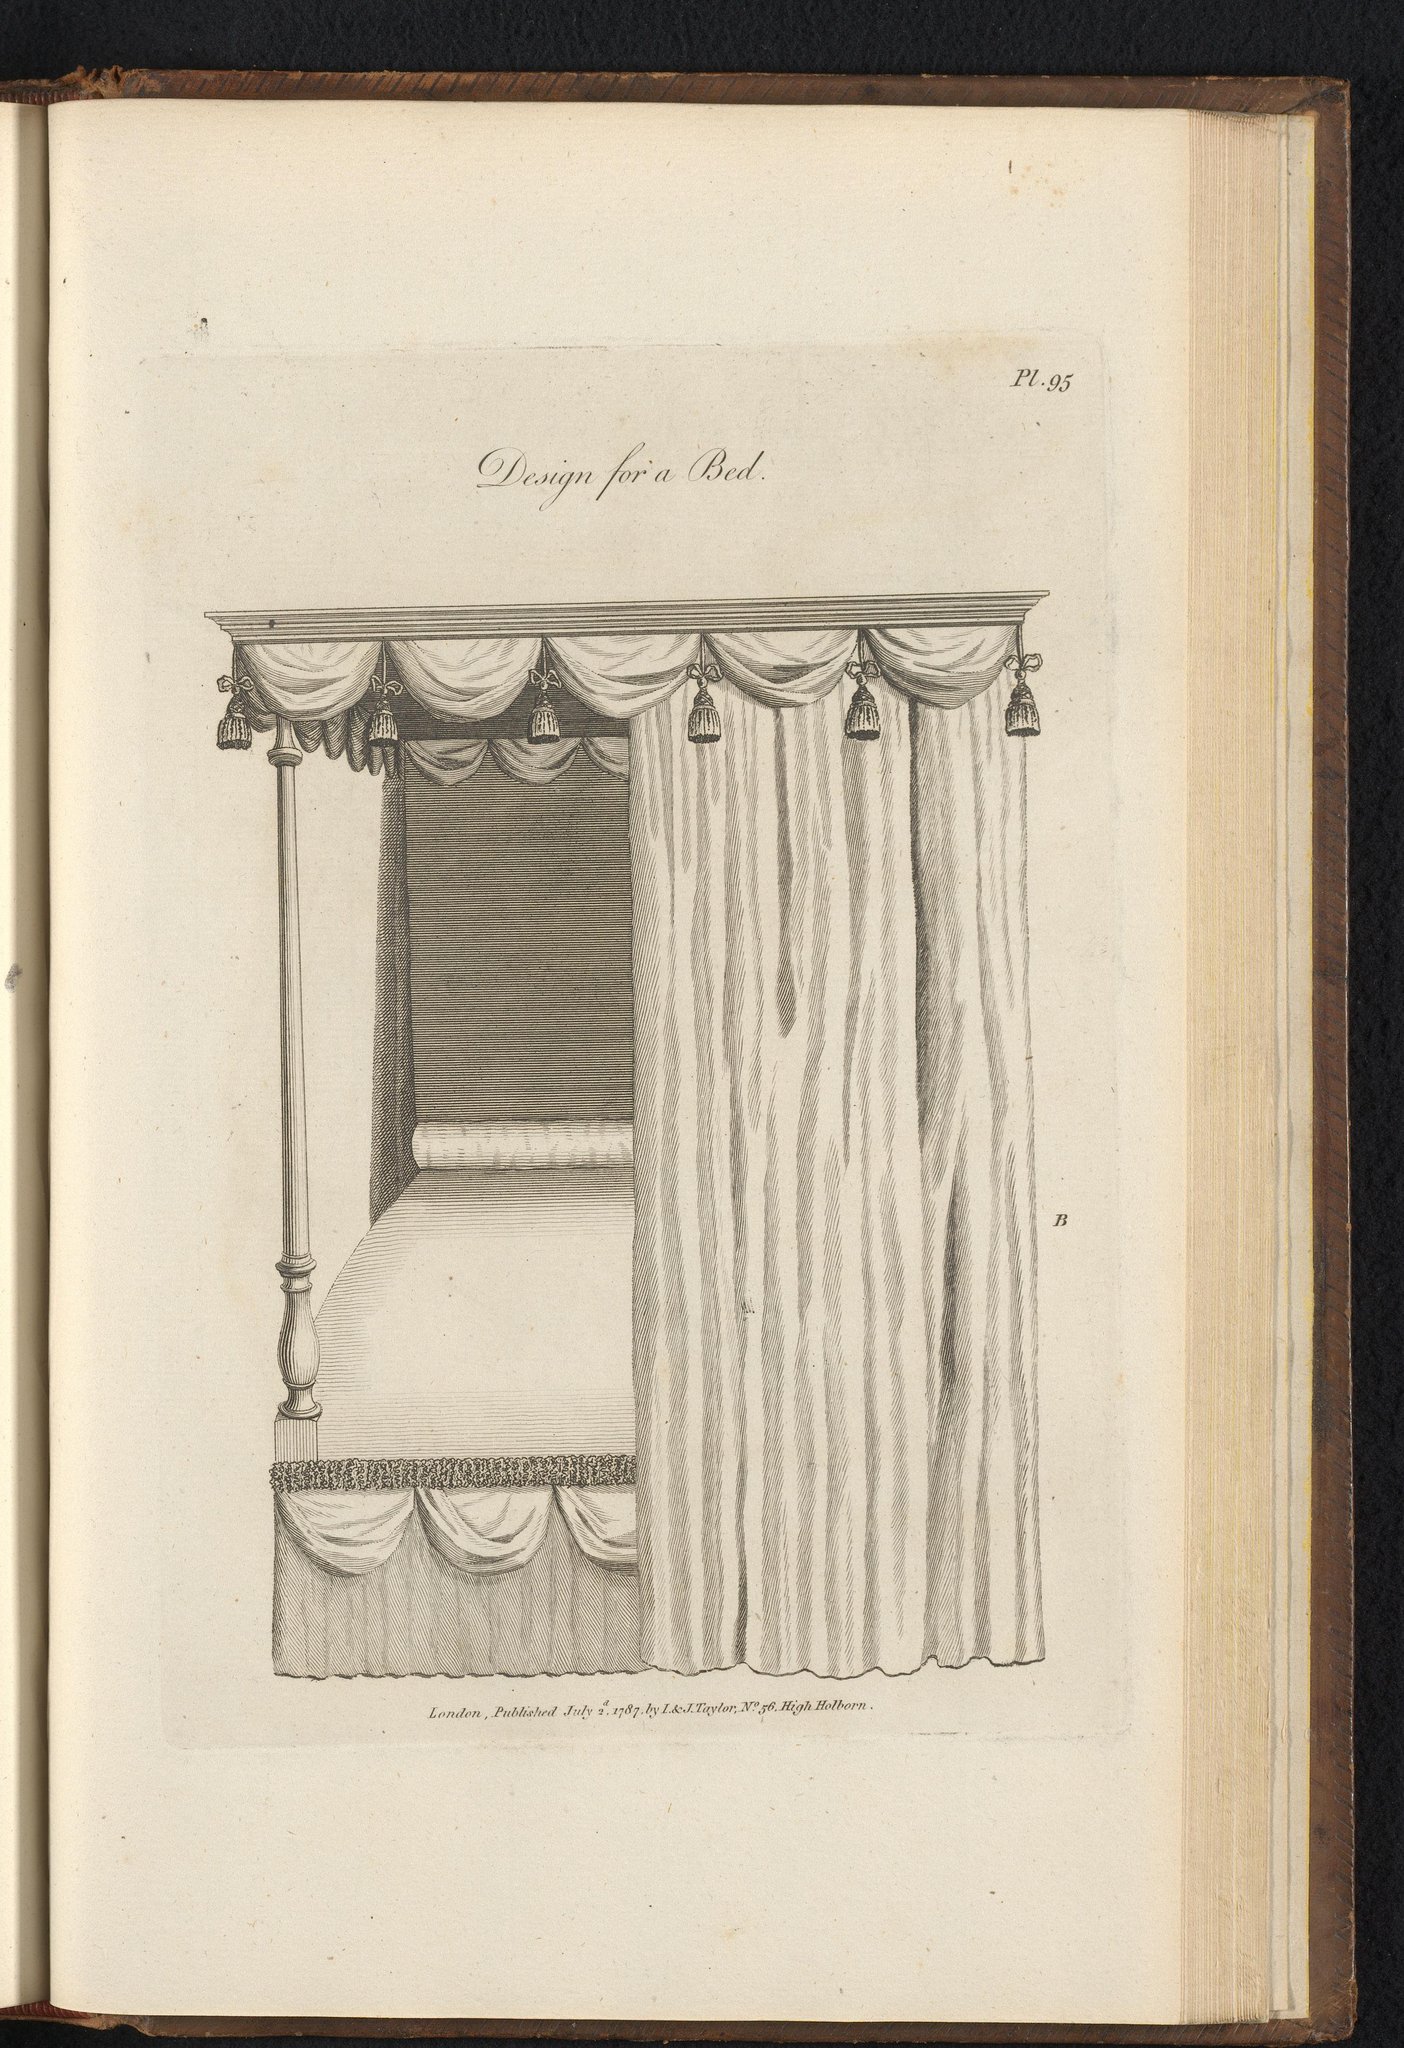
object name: page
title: Design for a Bed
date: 1787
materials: paper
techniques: engraving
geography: holborn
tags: bed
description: Genummerd: Pl. 95. Bed gemerkt als: B. Prent maakt deel uit van een boek.